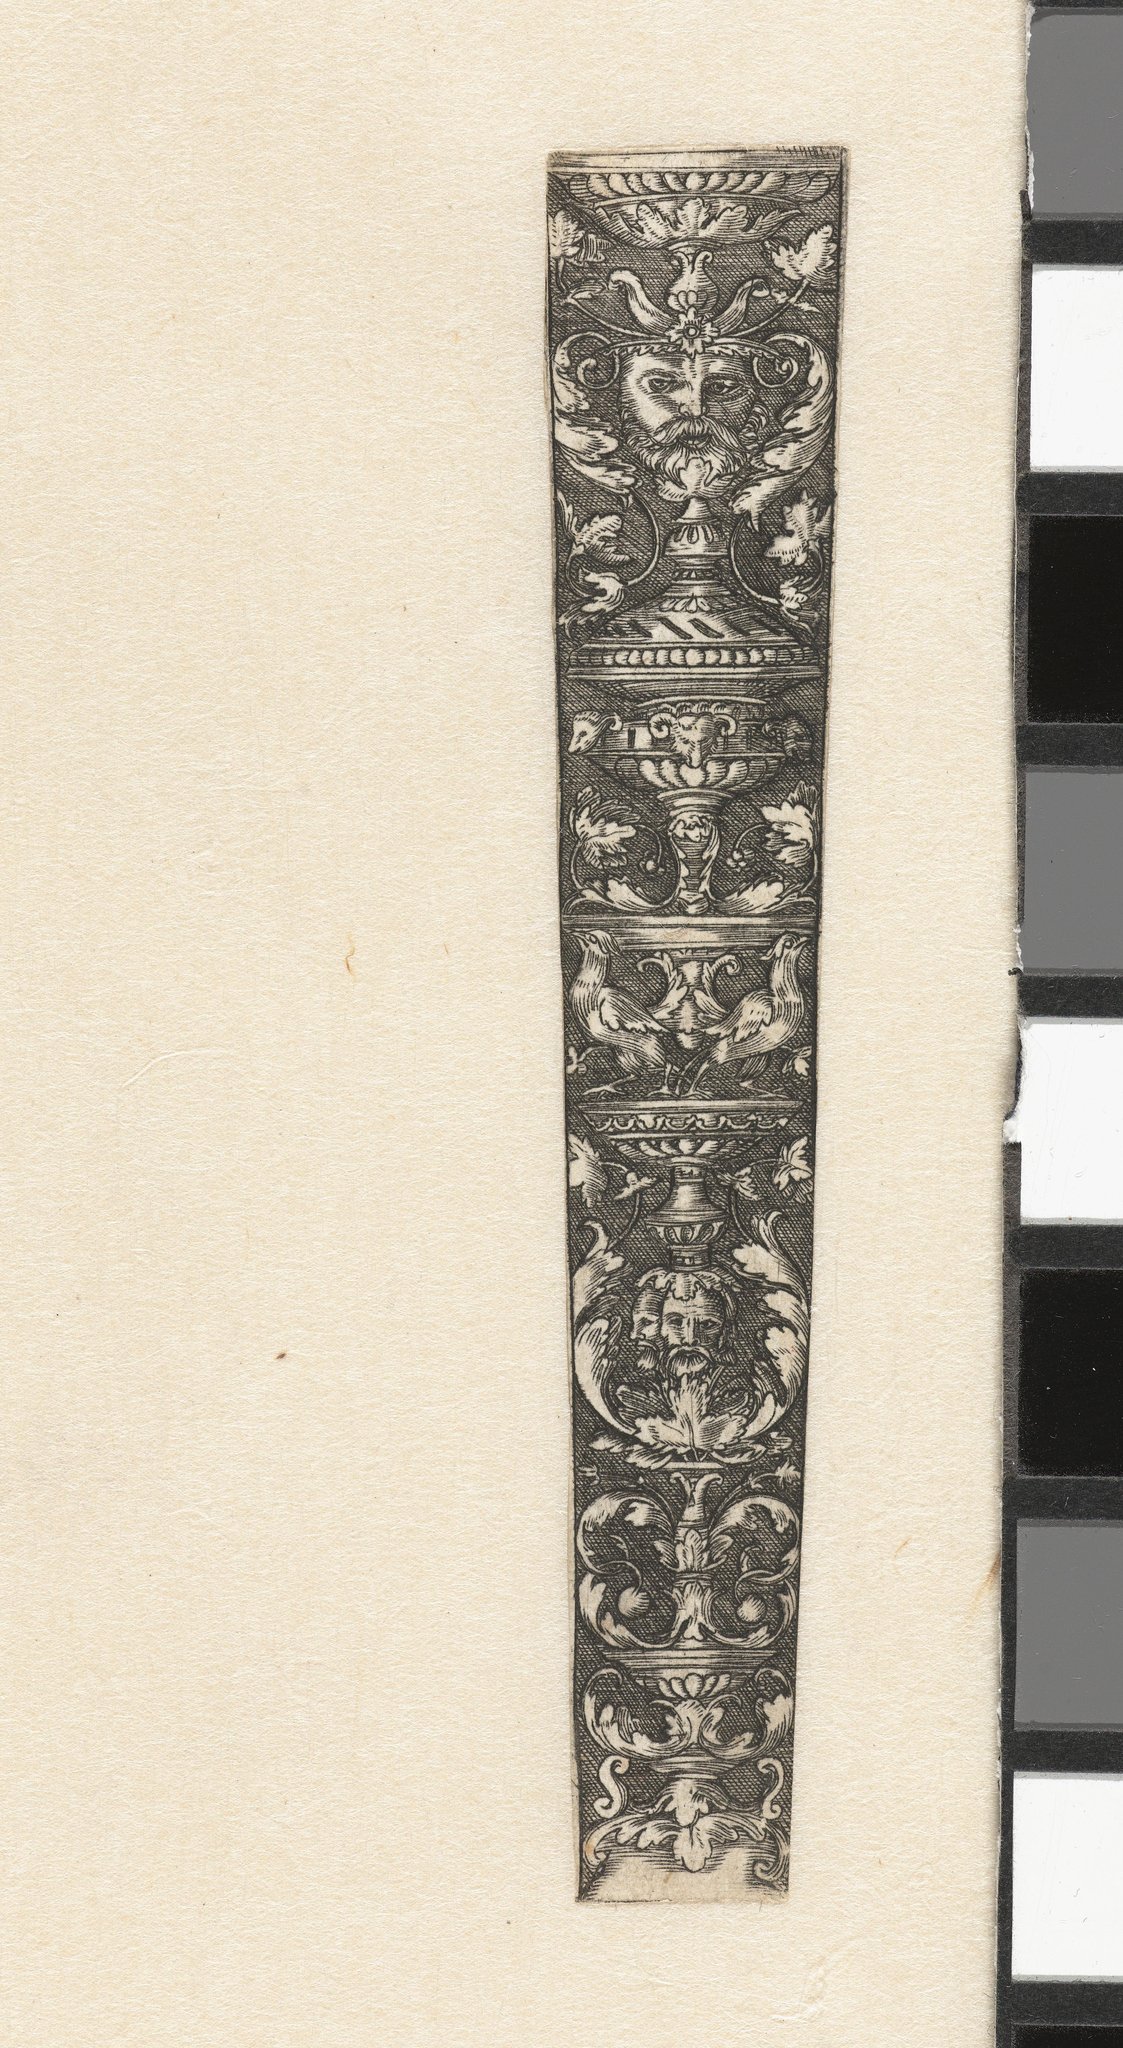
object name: print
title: Ornament met mascarons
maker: Anonymous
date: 1525-1580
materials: paper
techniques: engraving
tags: anthropomorphic ornament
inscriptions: collector's mark: Lugt 240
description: Onderste gedeelte van een schede. Een kadelaber met bladranken, mascarons, twee vogels en een mascaron met horens van voluten. Spiegelbeeldige kopie van een schede met Venus en Cupido door de Monogrammist IB.